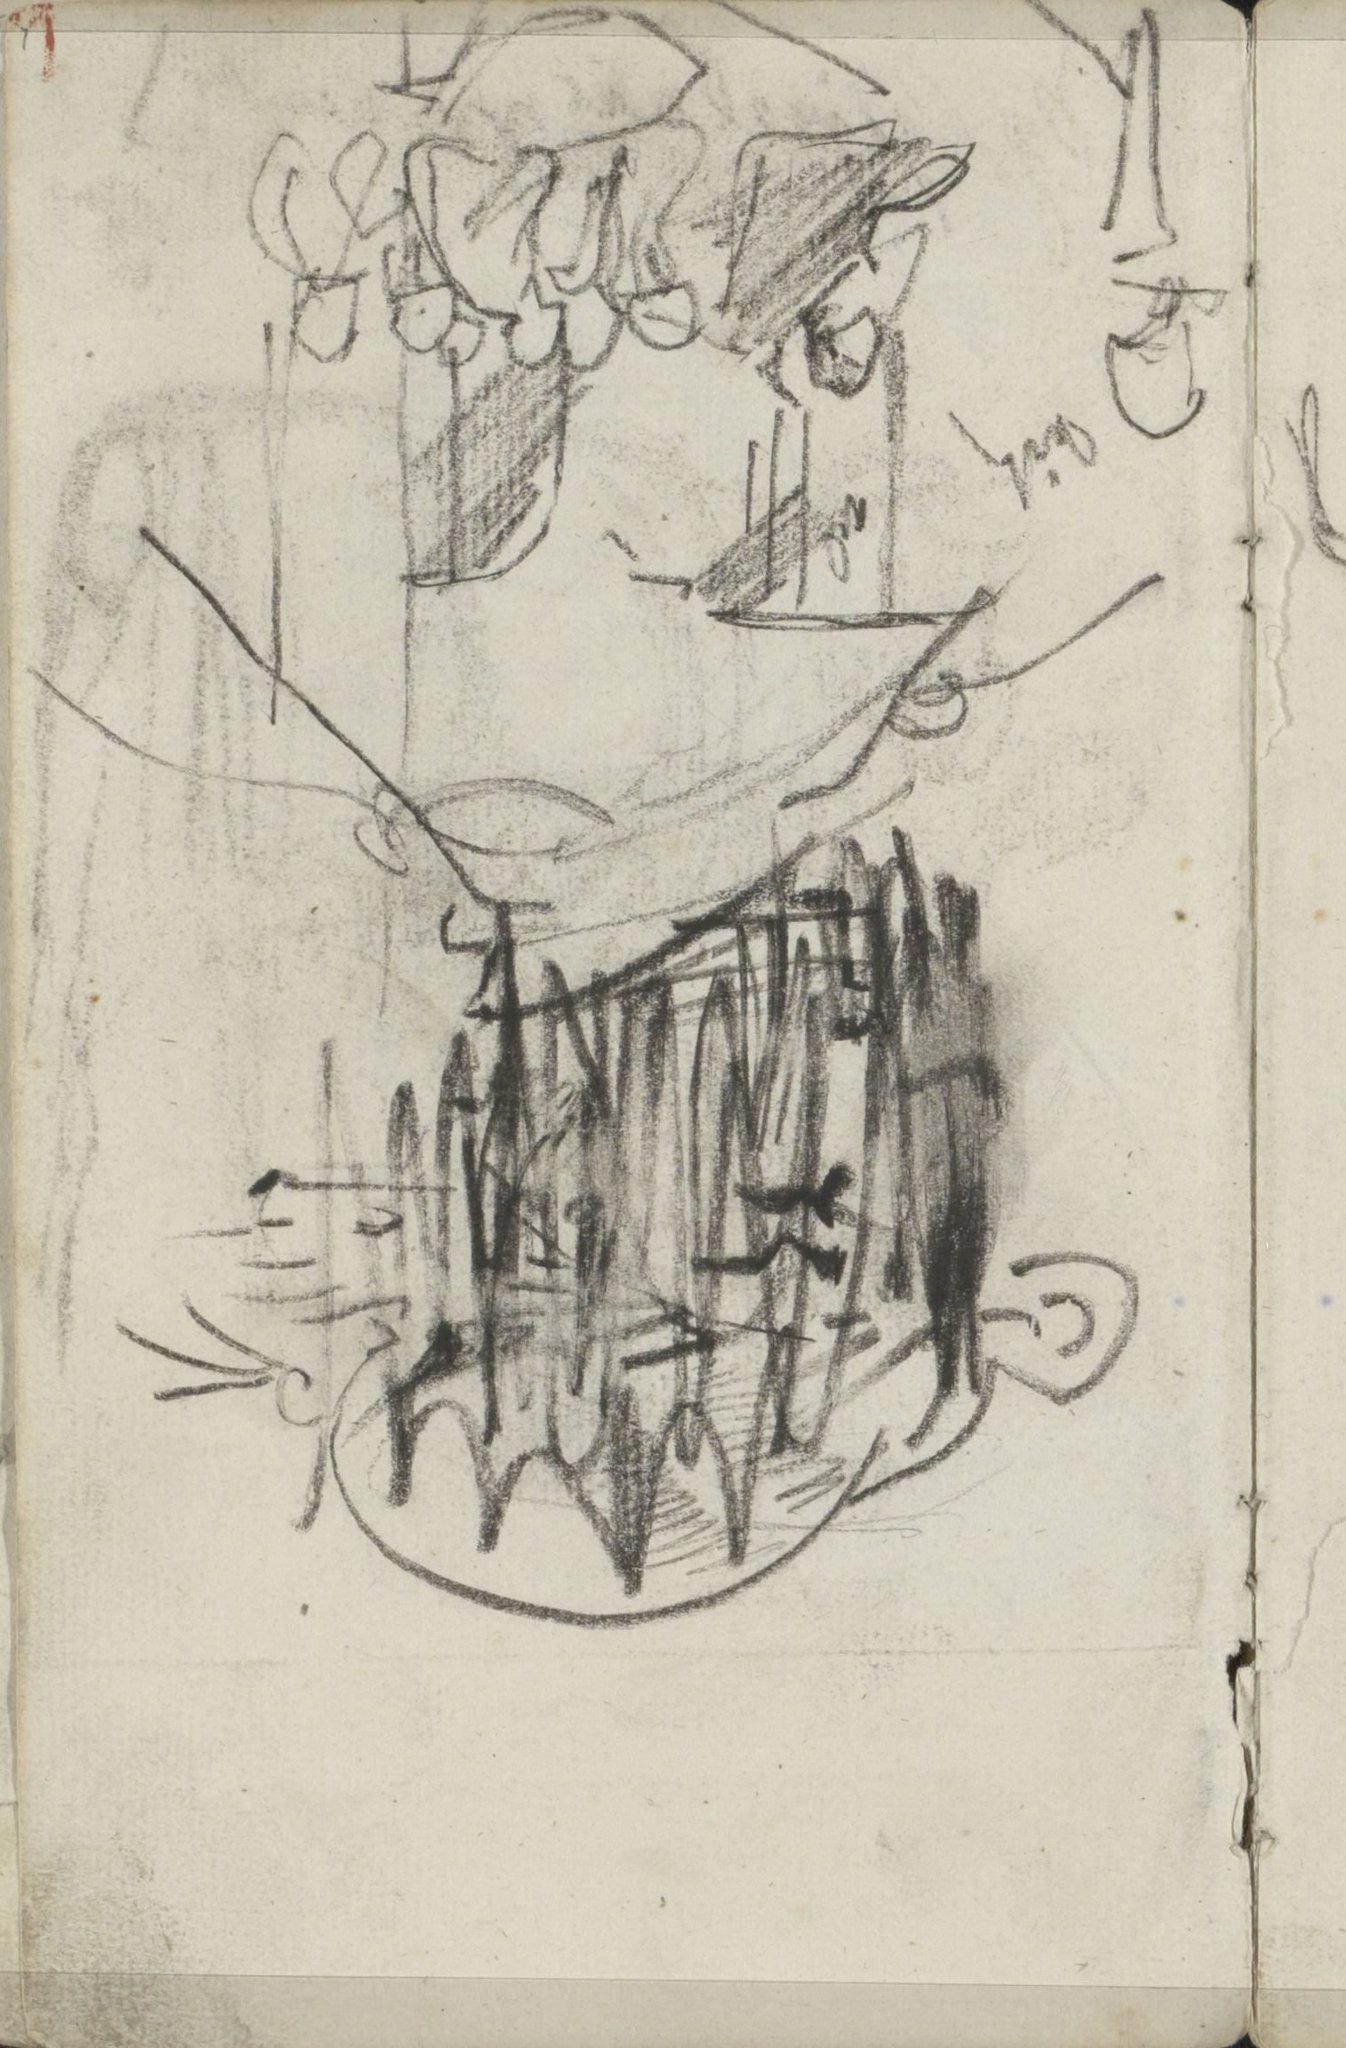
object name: sketchbook leaf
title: Groep figuren en en hoofd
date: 1881-1883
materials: chalk, paper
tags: adult woman, adult man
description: Mogelijk een voorstudie voor de tekening 'Soepuitdeling', 1882, Stedelijk Museum Amsterdam.